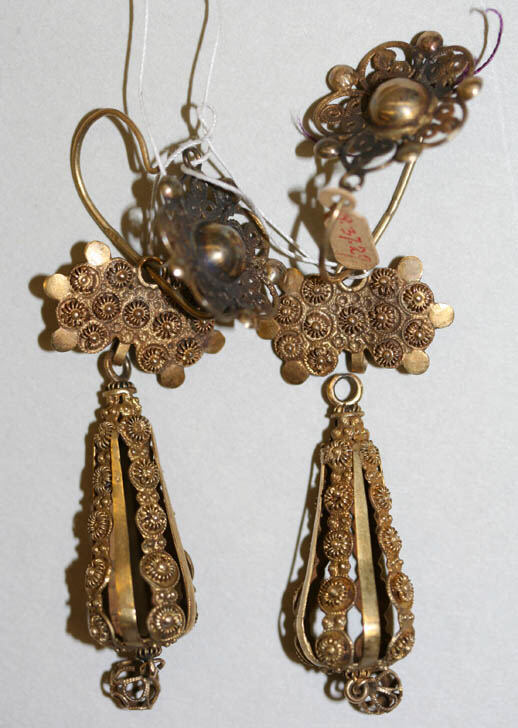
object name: earring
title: Earrings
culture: european, eastern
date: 1701-1900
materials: metal